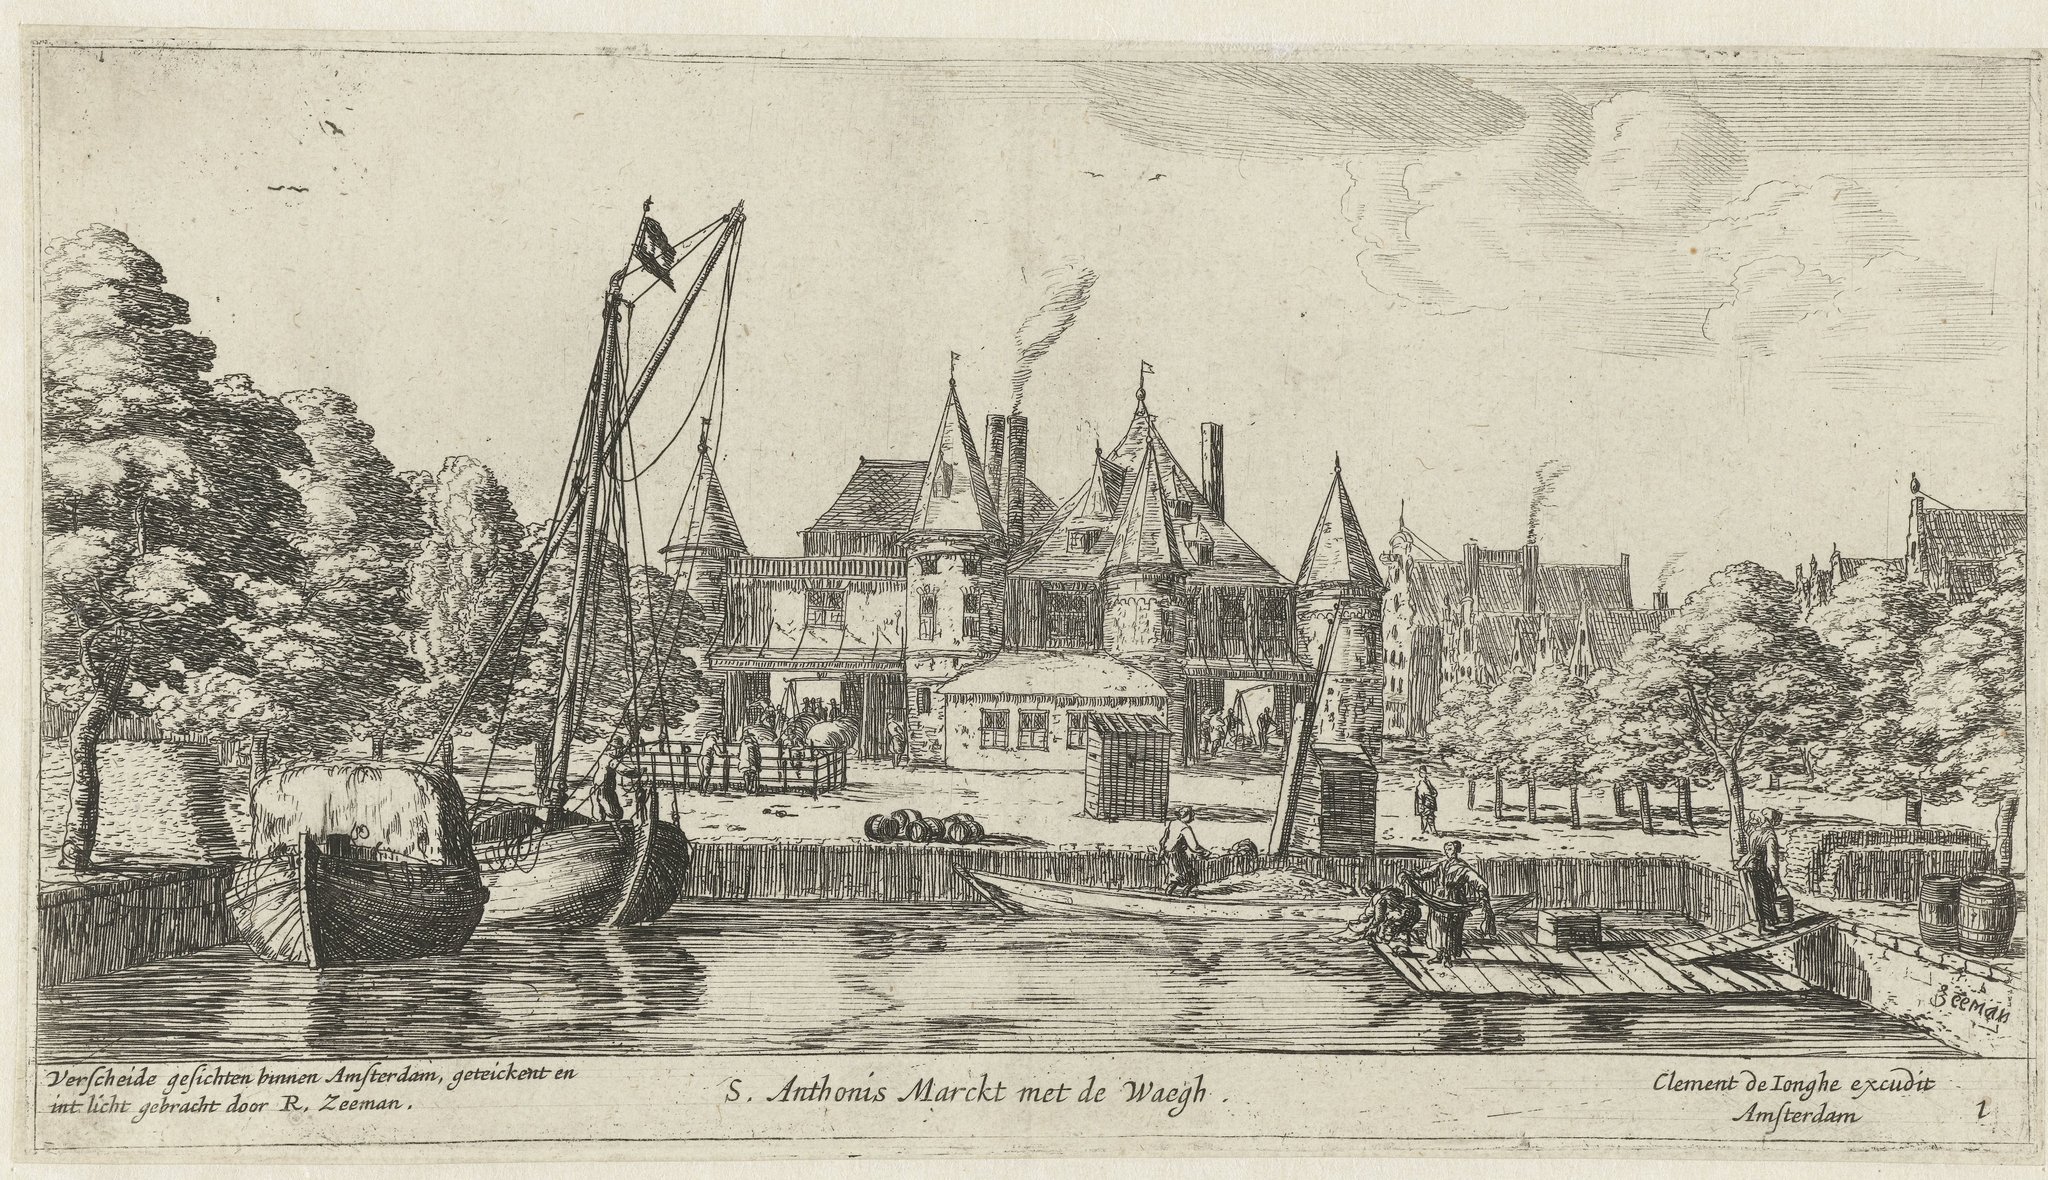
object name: print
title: S. Anthonis Marckt met de Waegh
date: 1657-1670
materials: paper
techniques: etching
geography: amsterdam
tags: city-view in general; 'veduta', amsterdam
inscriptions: collector's mark: Lugt 240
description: Gezicht vanaf het water op de huidige Nieuwmarkt en de Waag.